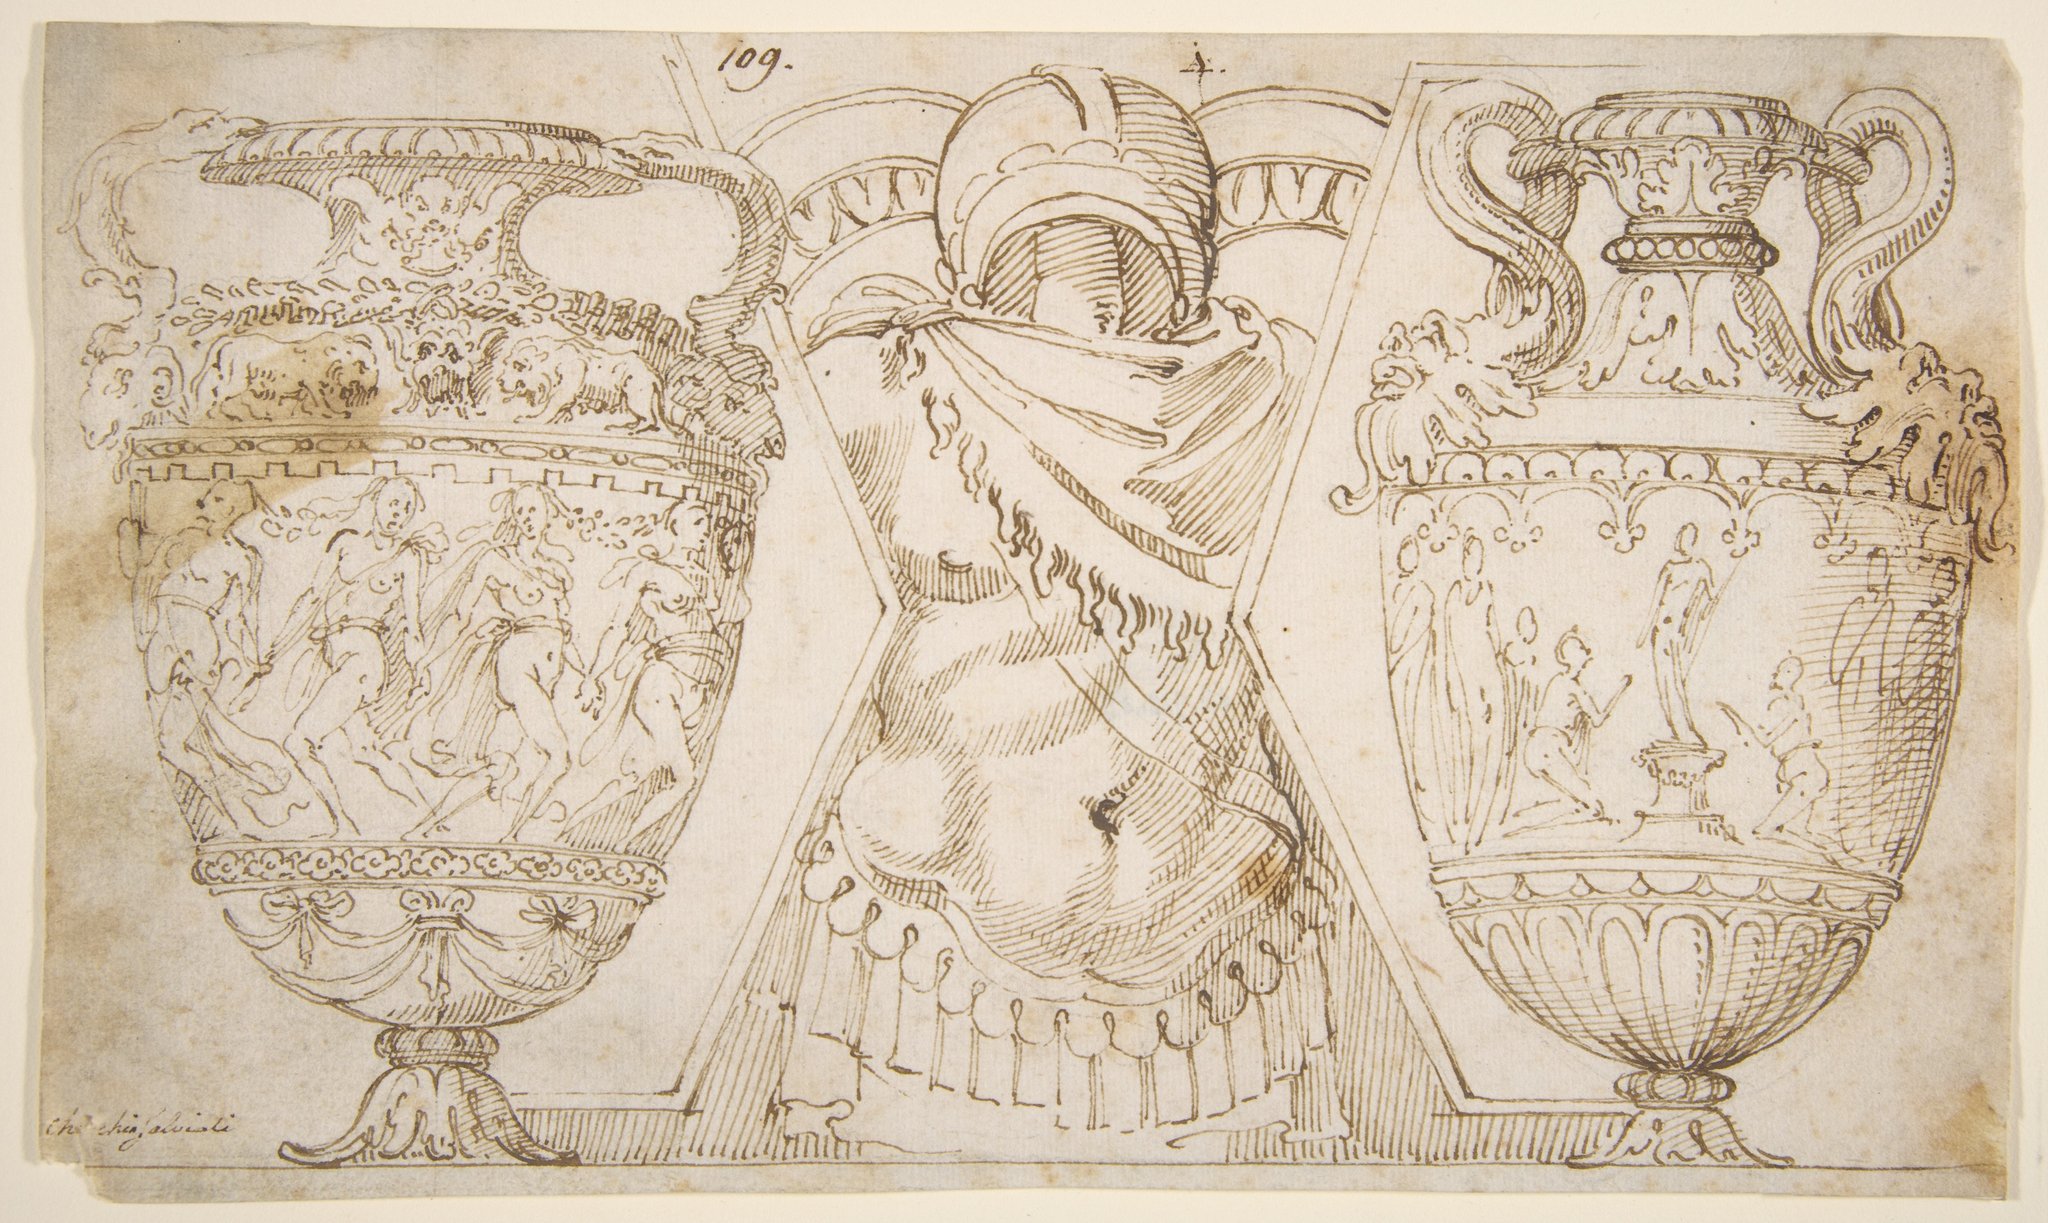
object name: drawing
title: Ornamental Design with Amphore and Antique Style Armor (recto); Sketch with Two Figures (verso)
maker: polidoro da caravaggio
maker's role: artist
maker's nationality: italian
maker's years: 1494-1548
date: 1501-1600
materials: chalk, graphite, ink, drawing material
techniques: pen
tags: armor,vases